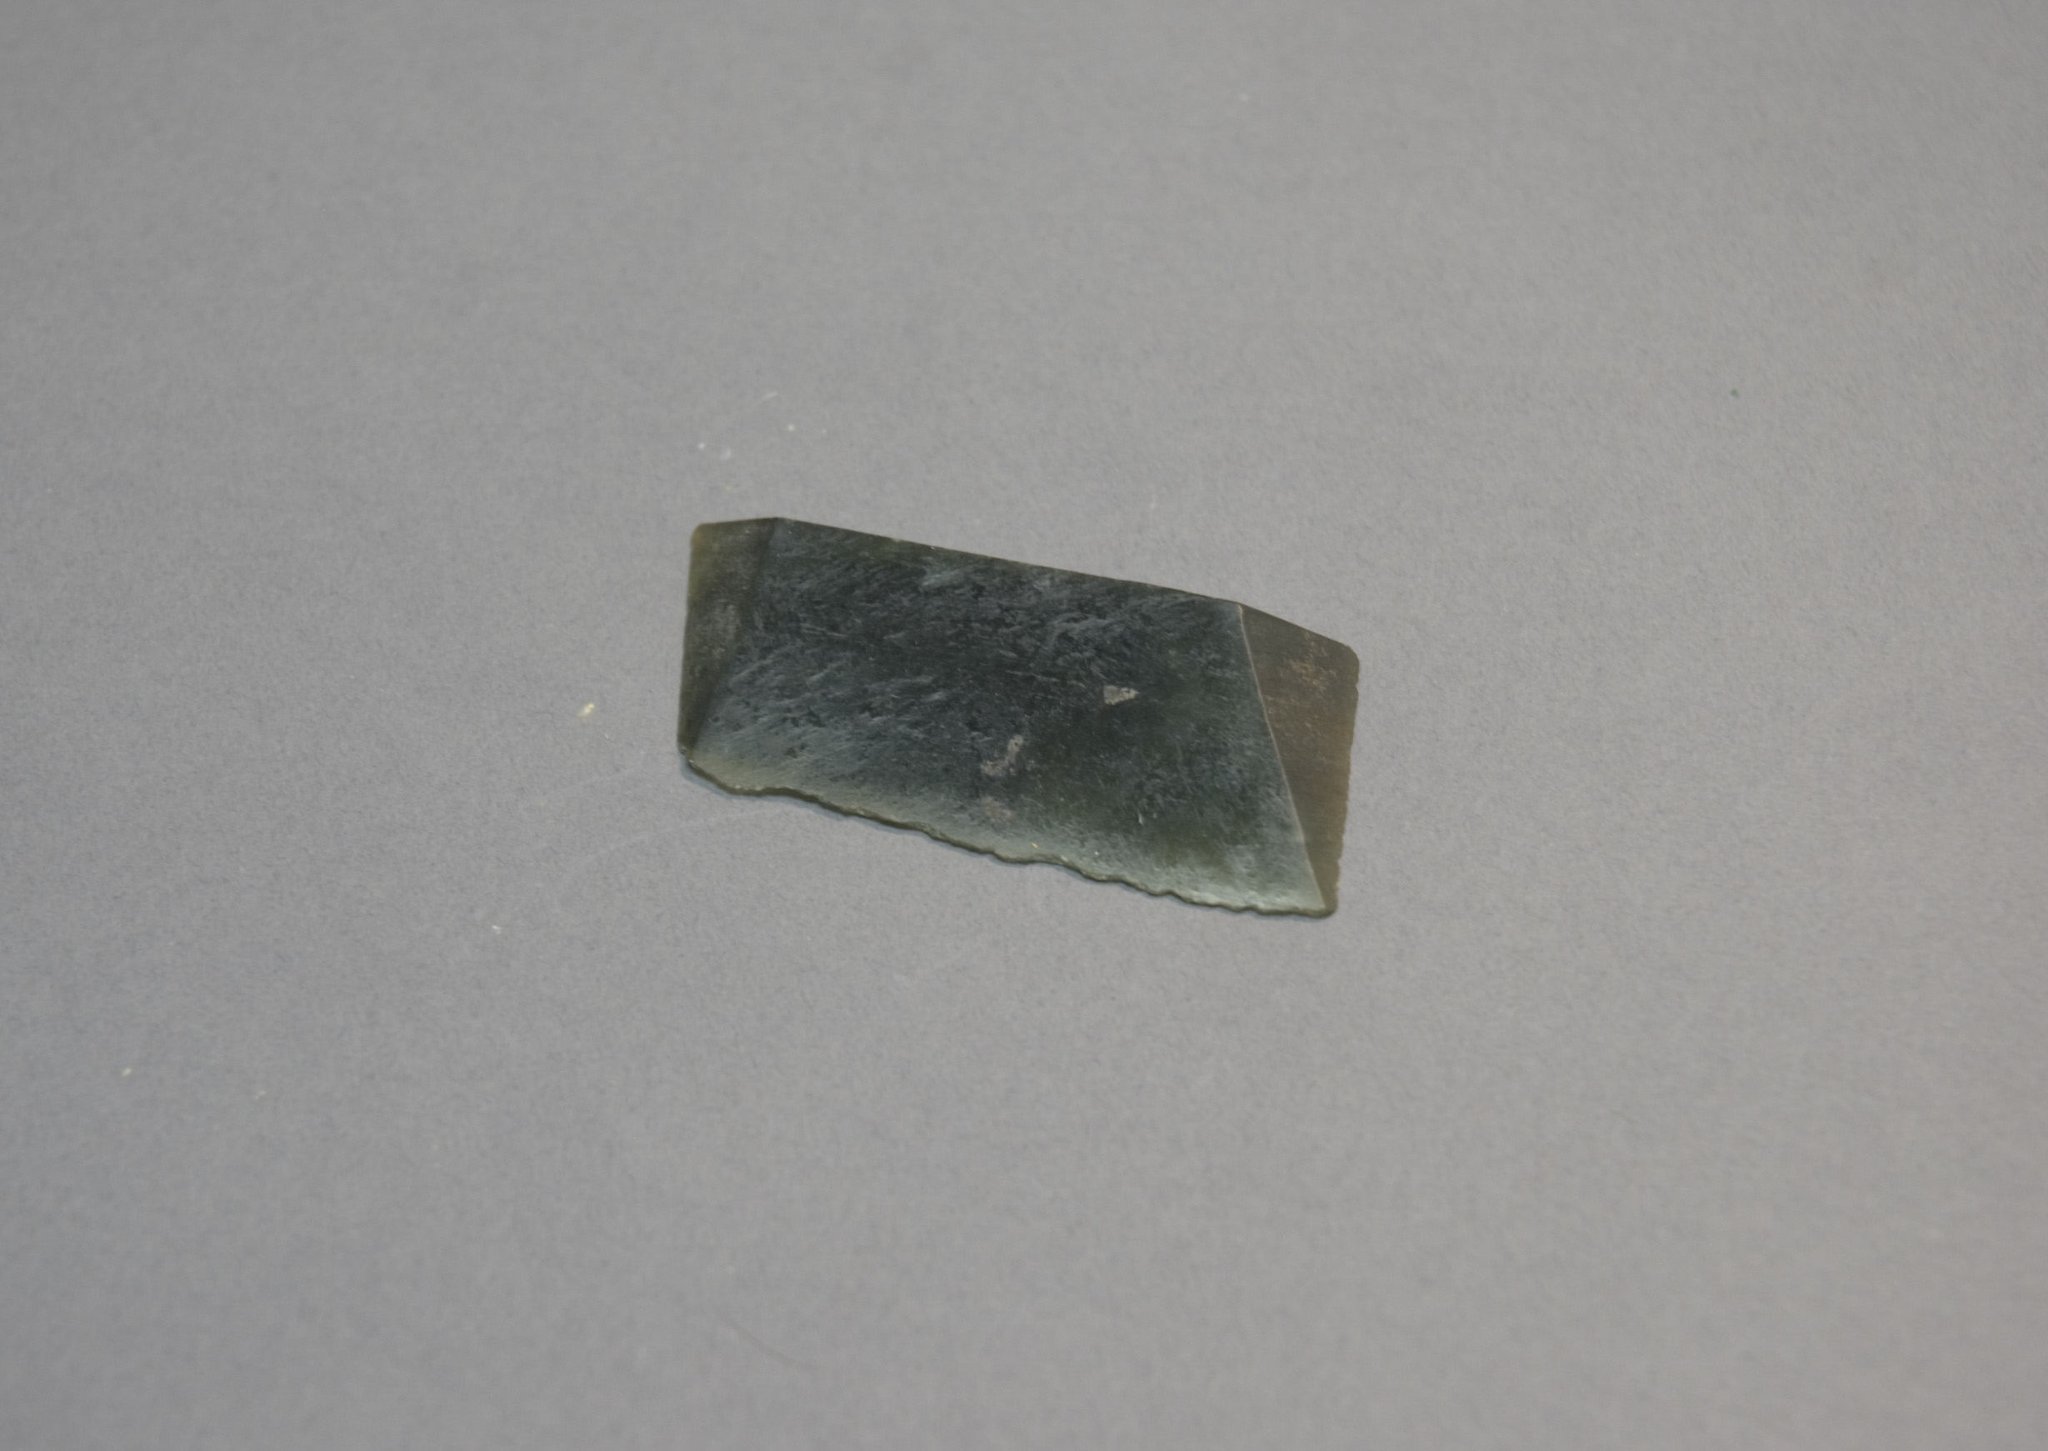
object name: jade carving material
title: Sample of Siberian Nephrite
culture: chinese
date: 1901-2000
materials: jade